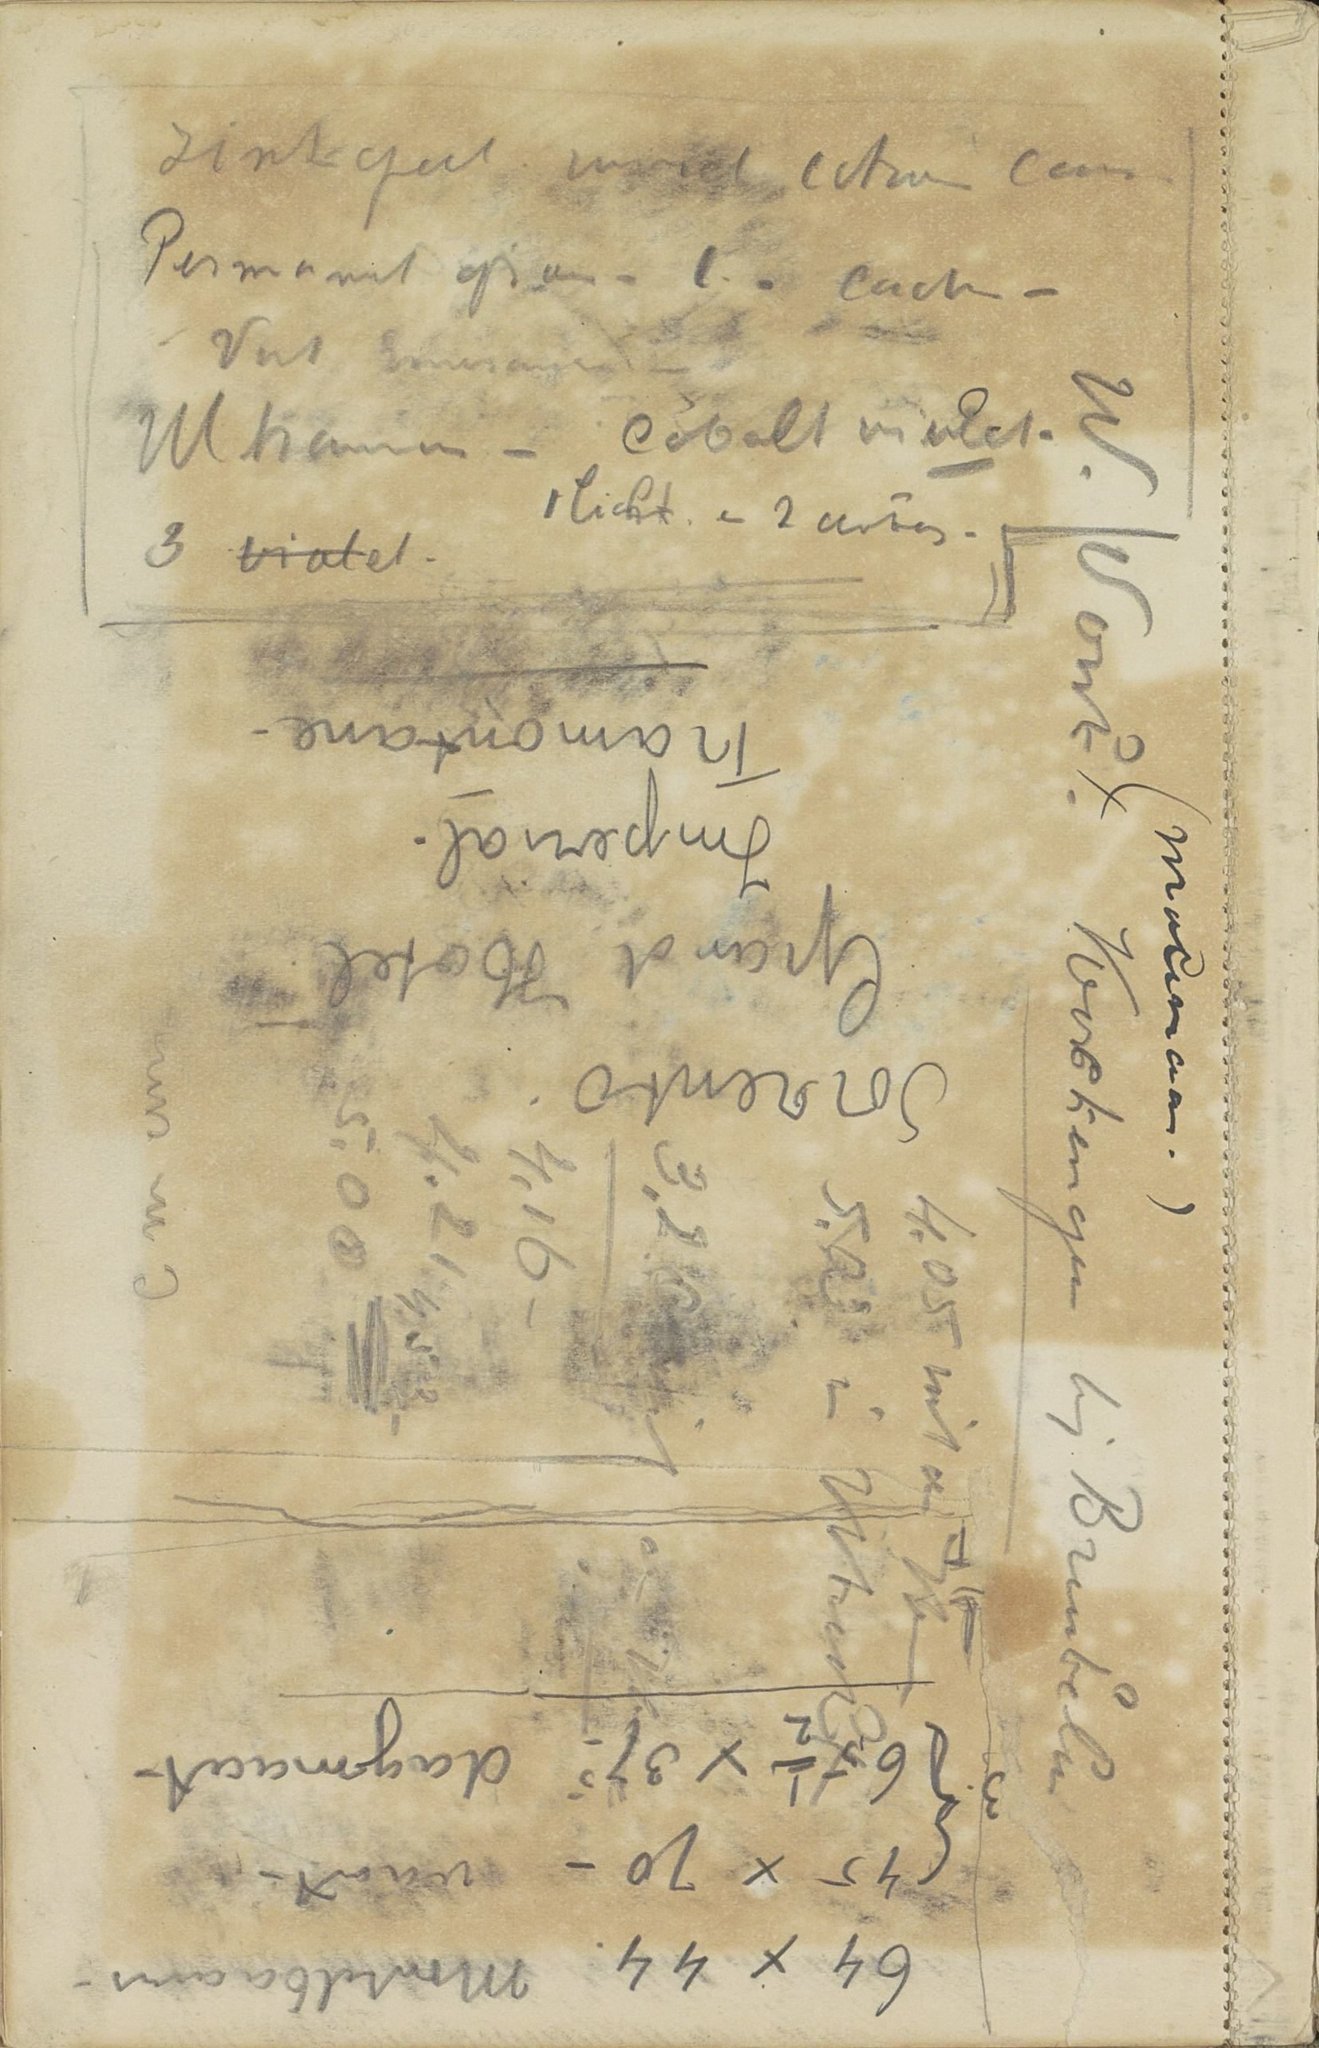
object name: sketchbook leaf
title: Notities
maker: cornelis vreedenburgh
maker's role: draughtsman, print maker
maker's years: 1880-1946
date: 1890-1946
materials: ink, paper, pencil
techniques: pen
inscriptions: annotation: ‘(molenaar)/ [...]’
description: Blad 56 verso uit een schetsboek met 56 bladen.